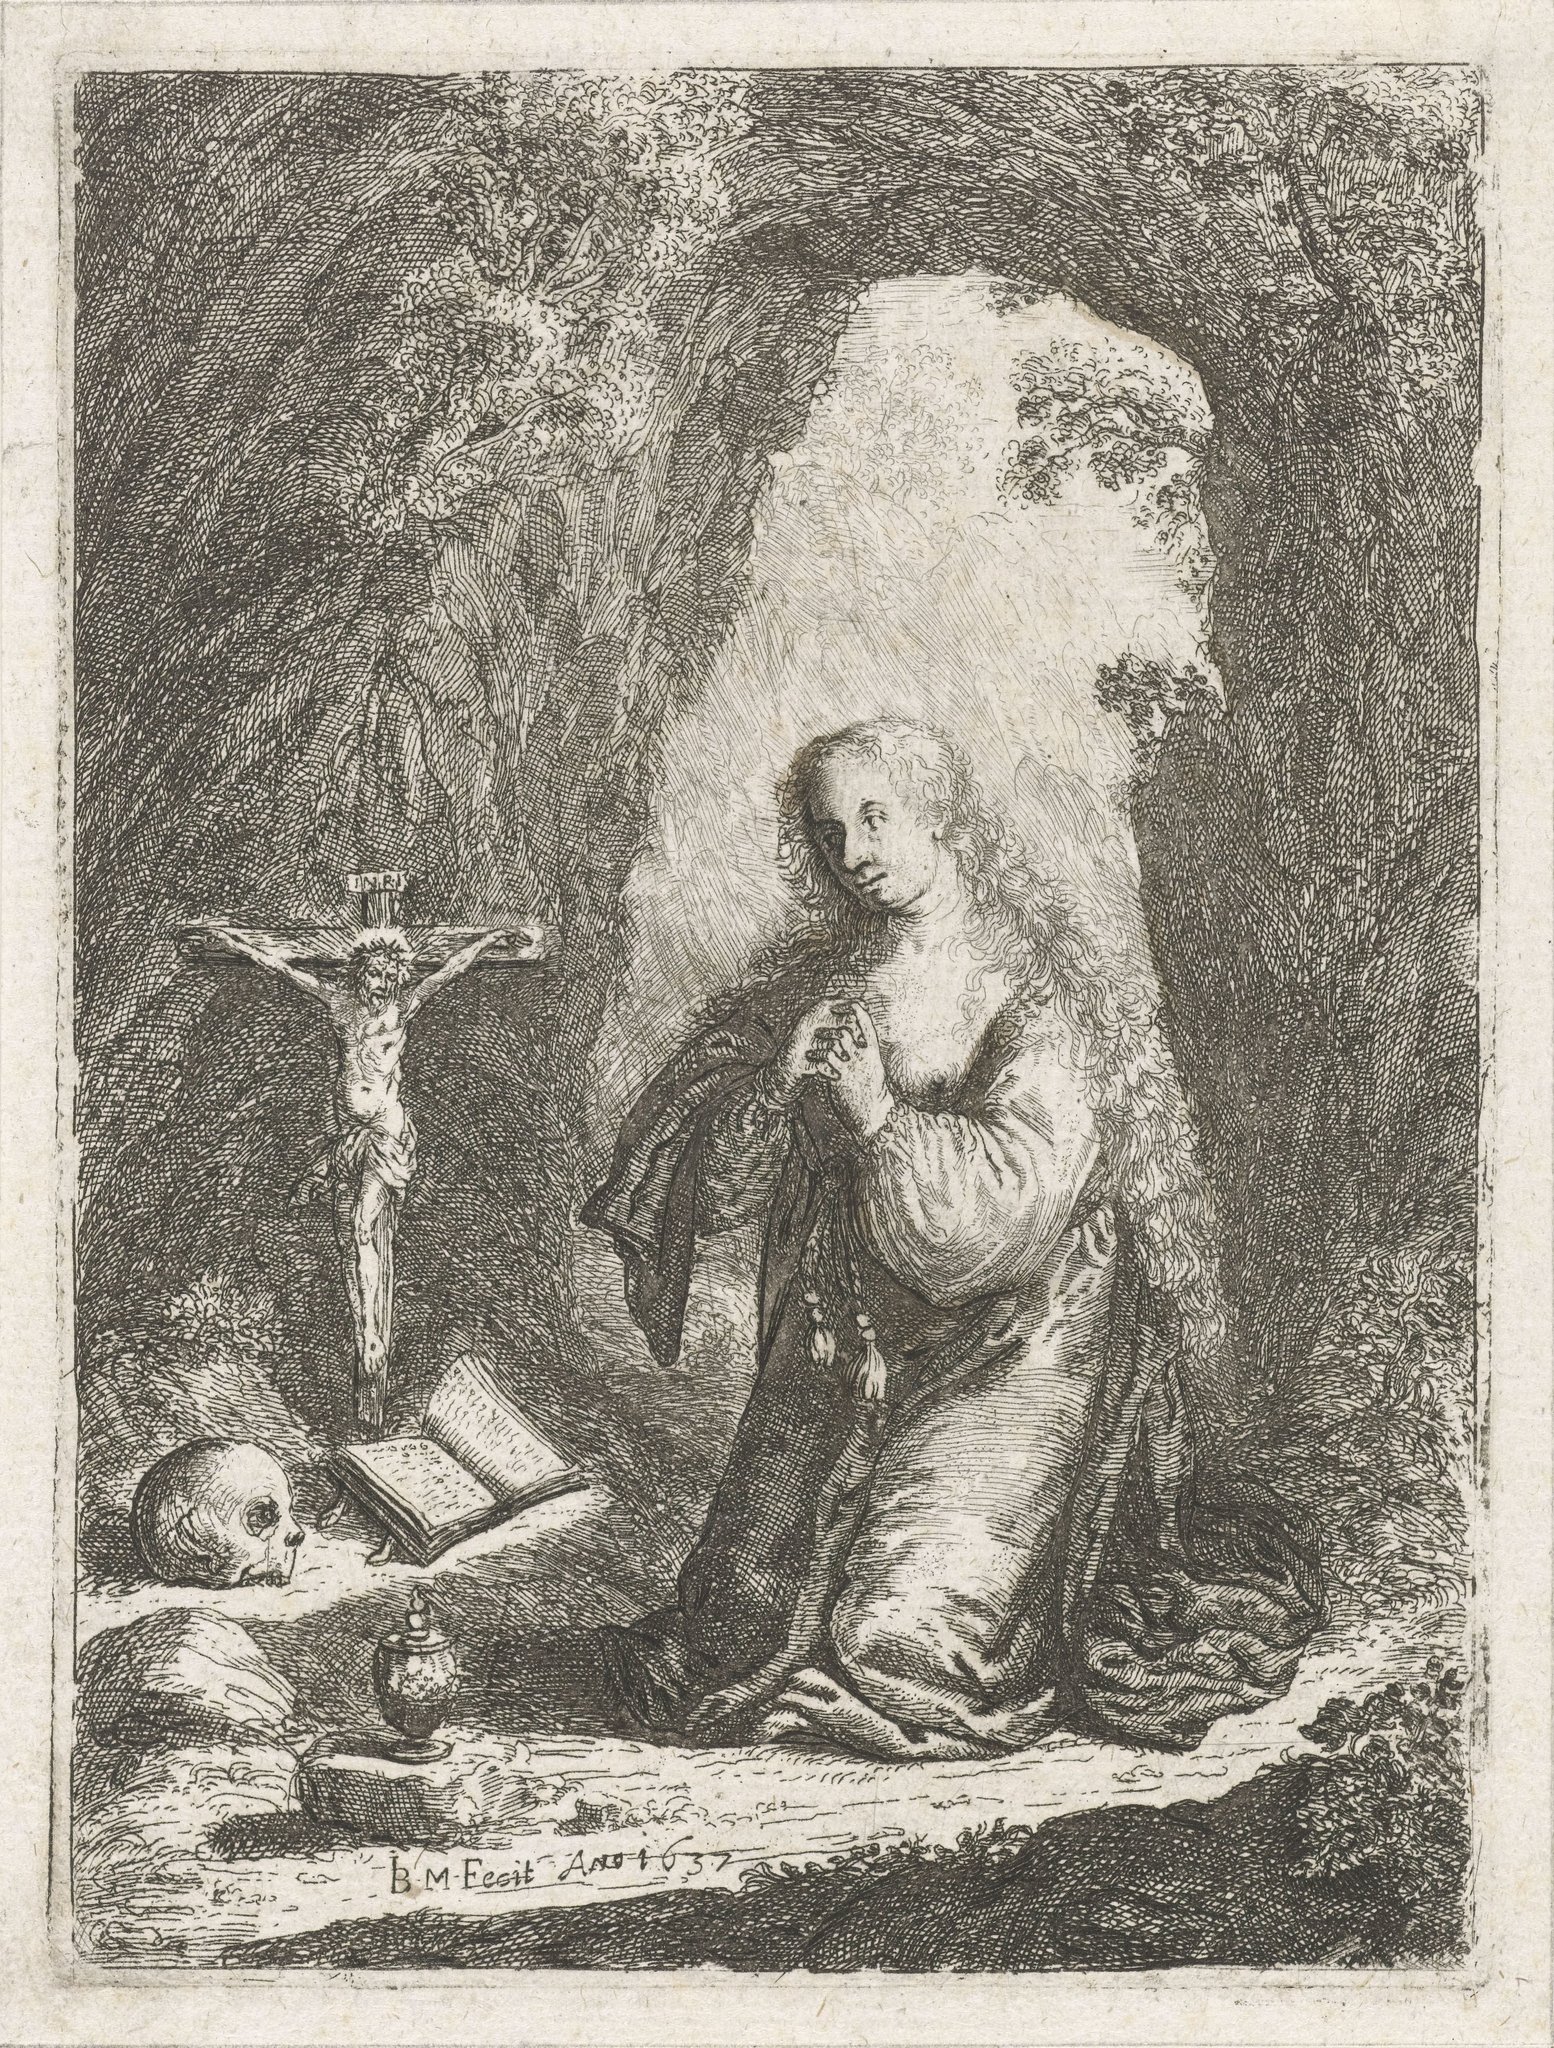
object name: print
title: Boetvaardige Maria Magdalena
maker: jan barentsz. muyckens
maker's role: print maker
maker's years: 1595-1665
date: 1637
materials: paper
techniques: etching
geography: amsterdam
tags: the penitent st. mary magdalene (often before a cave, possibly at la sainte-baume hill): her long hair covers her (naked) body, she reads, meditates or raises her tear-filled eyes towards heaven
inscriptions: collector's mark: Lugt 514, collector's mark: Lugt 2228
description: De boetvaardige Maria Magdalena geknield op de grond bij een crucifix, een opengeslagen boek en een schedel. Voor haar staat de zalfpot. Op de achtergrond de opening van een grot.